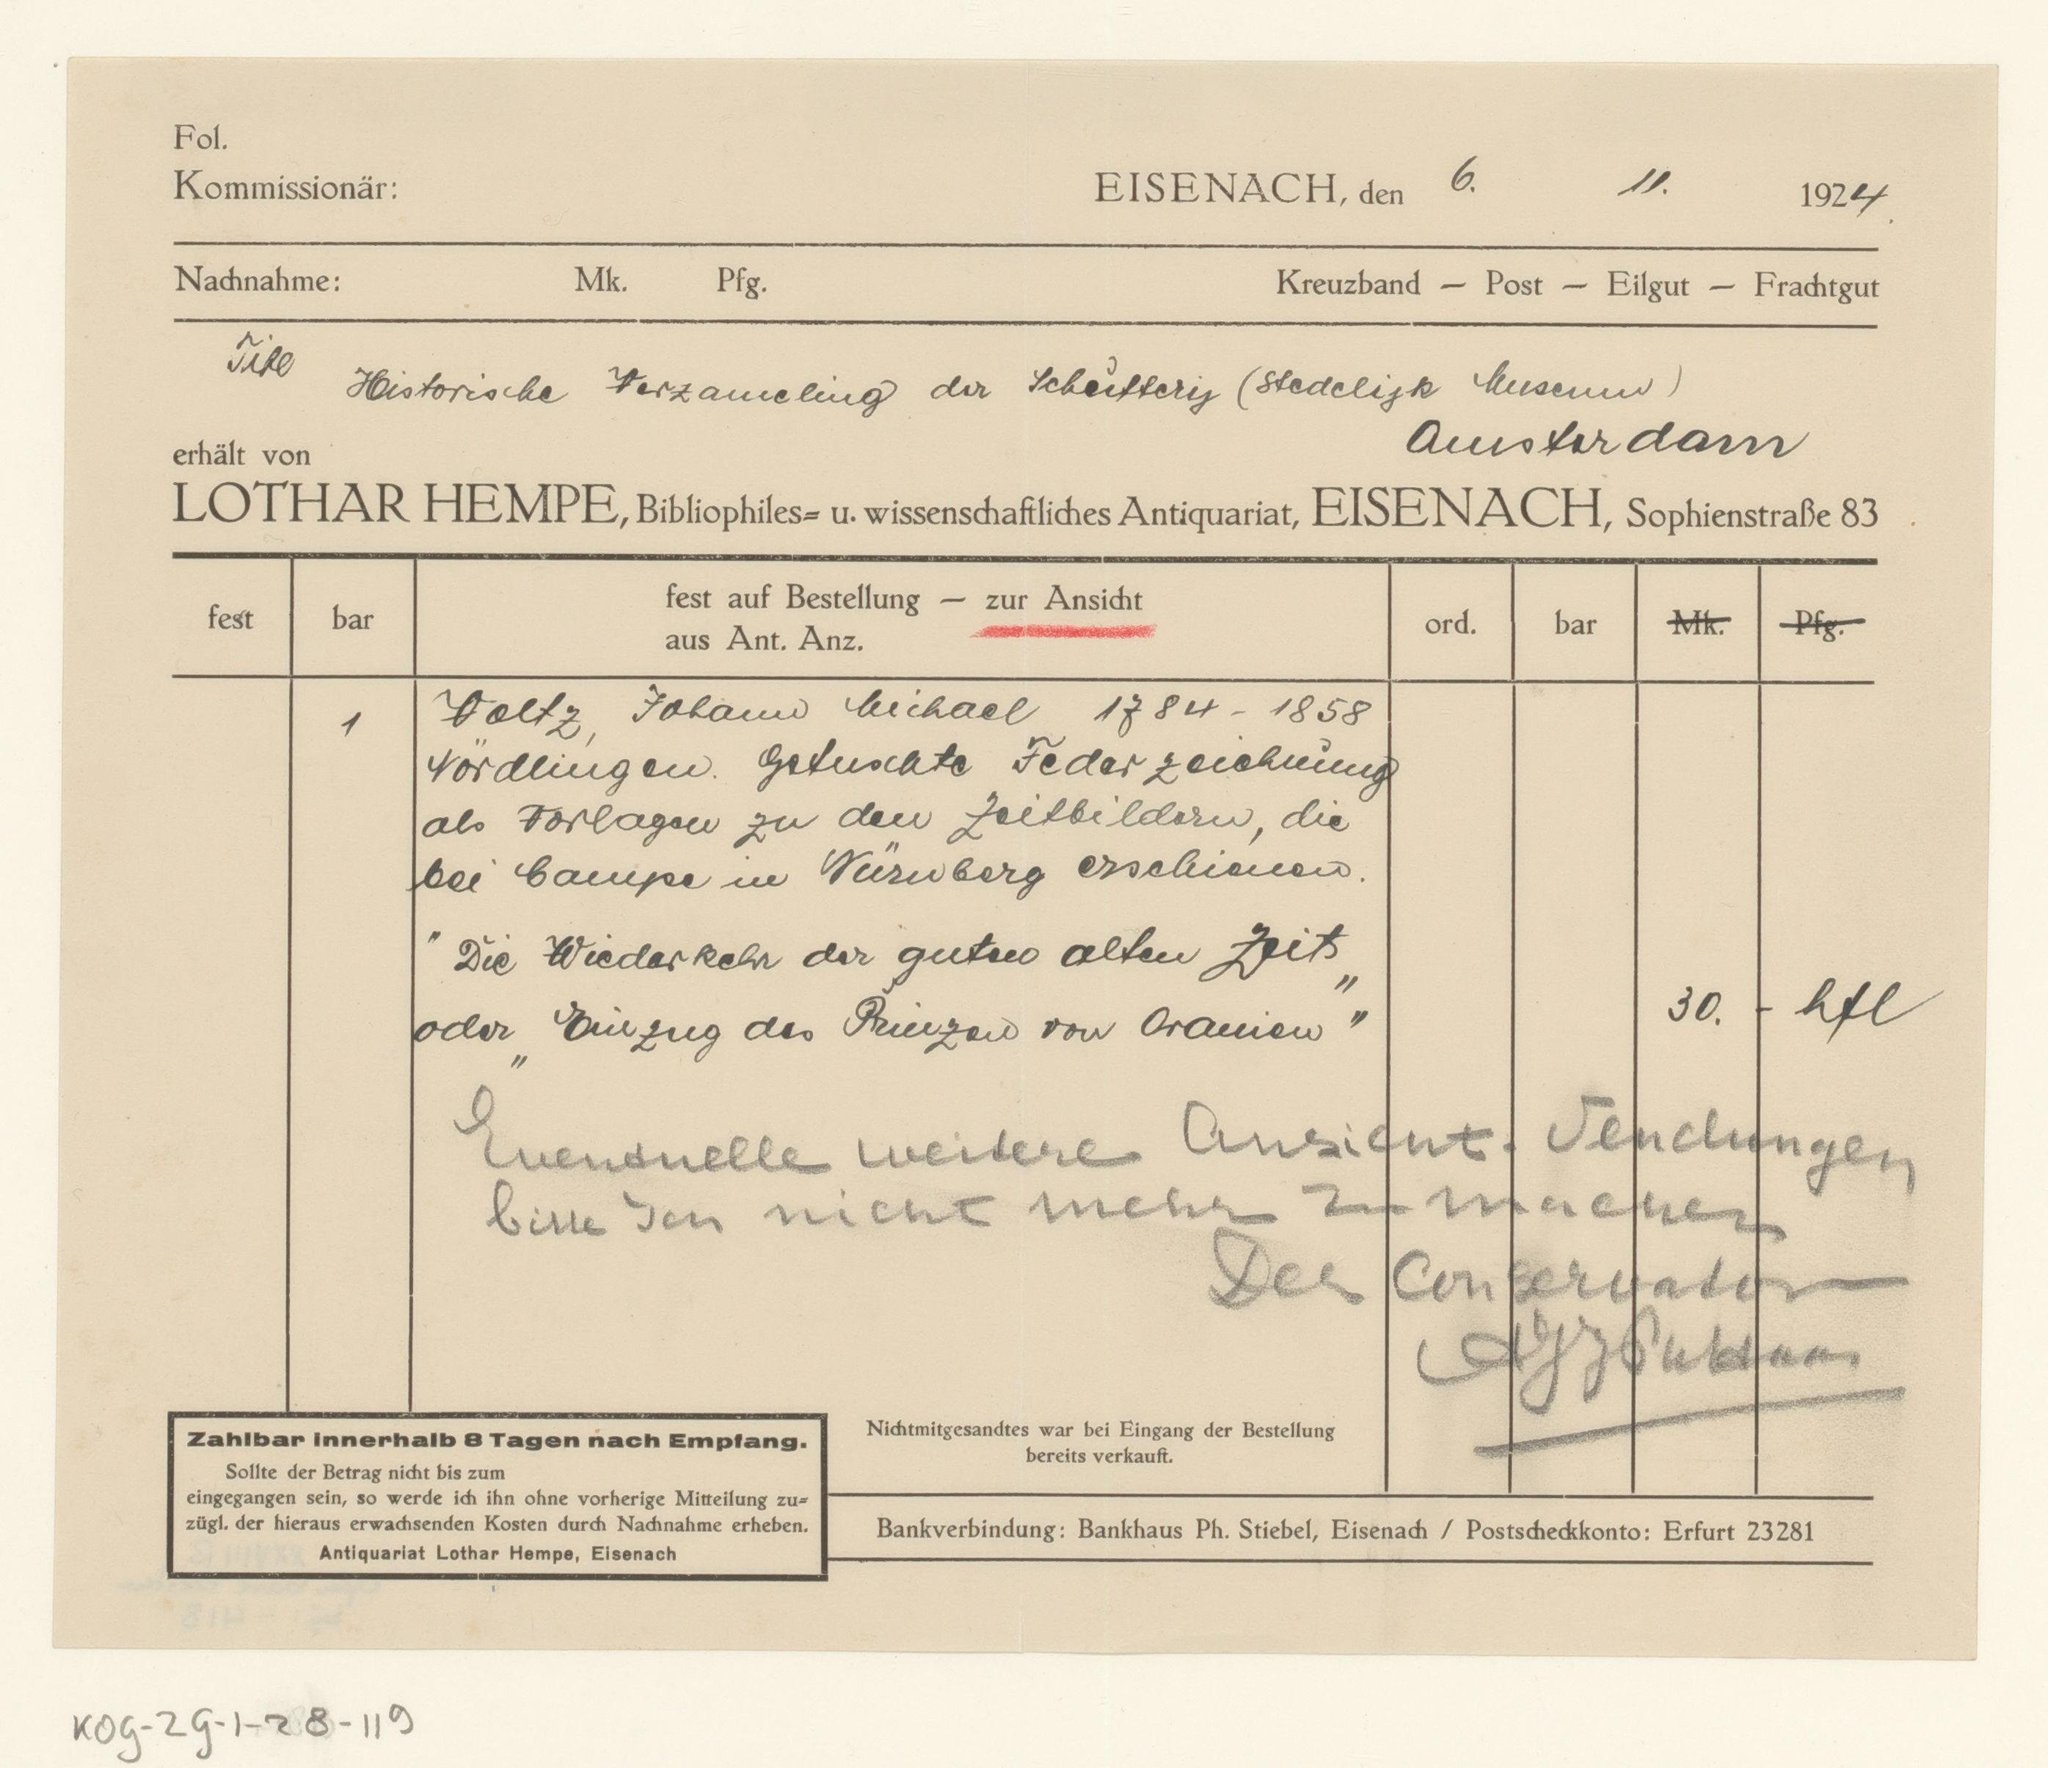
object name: voucher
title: Bon voor Komst van de Soeverein Vorst te Amsterdam, 1813 door Johann Michael Voltz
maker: Anonymous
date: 1924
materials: ink, paper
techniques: letterpress printing, pen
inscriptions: collector's mark: Lugt 1641, stamp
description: Bon voor Komst van de Soeverein Vorst te Amsterdam, 1813 door Johann Michael Voltz. Aangekocht bij antiquariaat Lothar Hempe. Onderwerpsrubrieken binnen de Atlas Zeden en Gewoonten: Zeden en Gewoonten in Engeren Zin. Volksleven. Openbare feesten. Vorstelijke intochten, (Illuminaties, vuurwerken en dergelijke, openbare feesten).